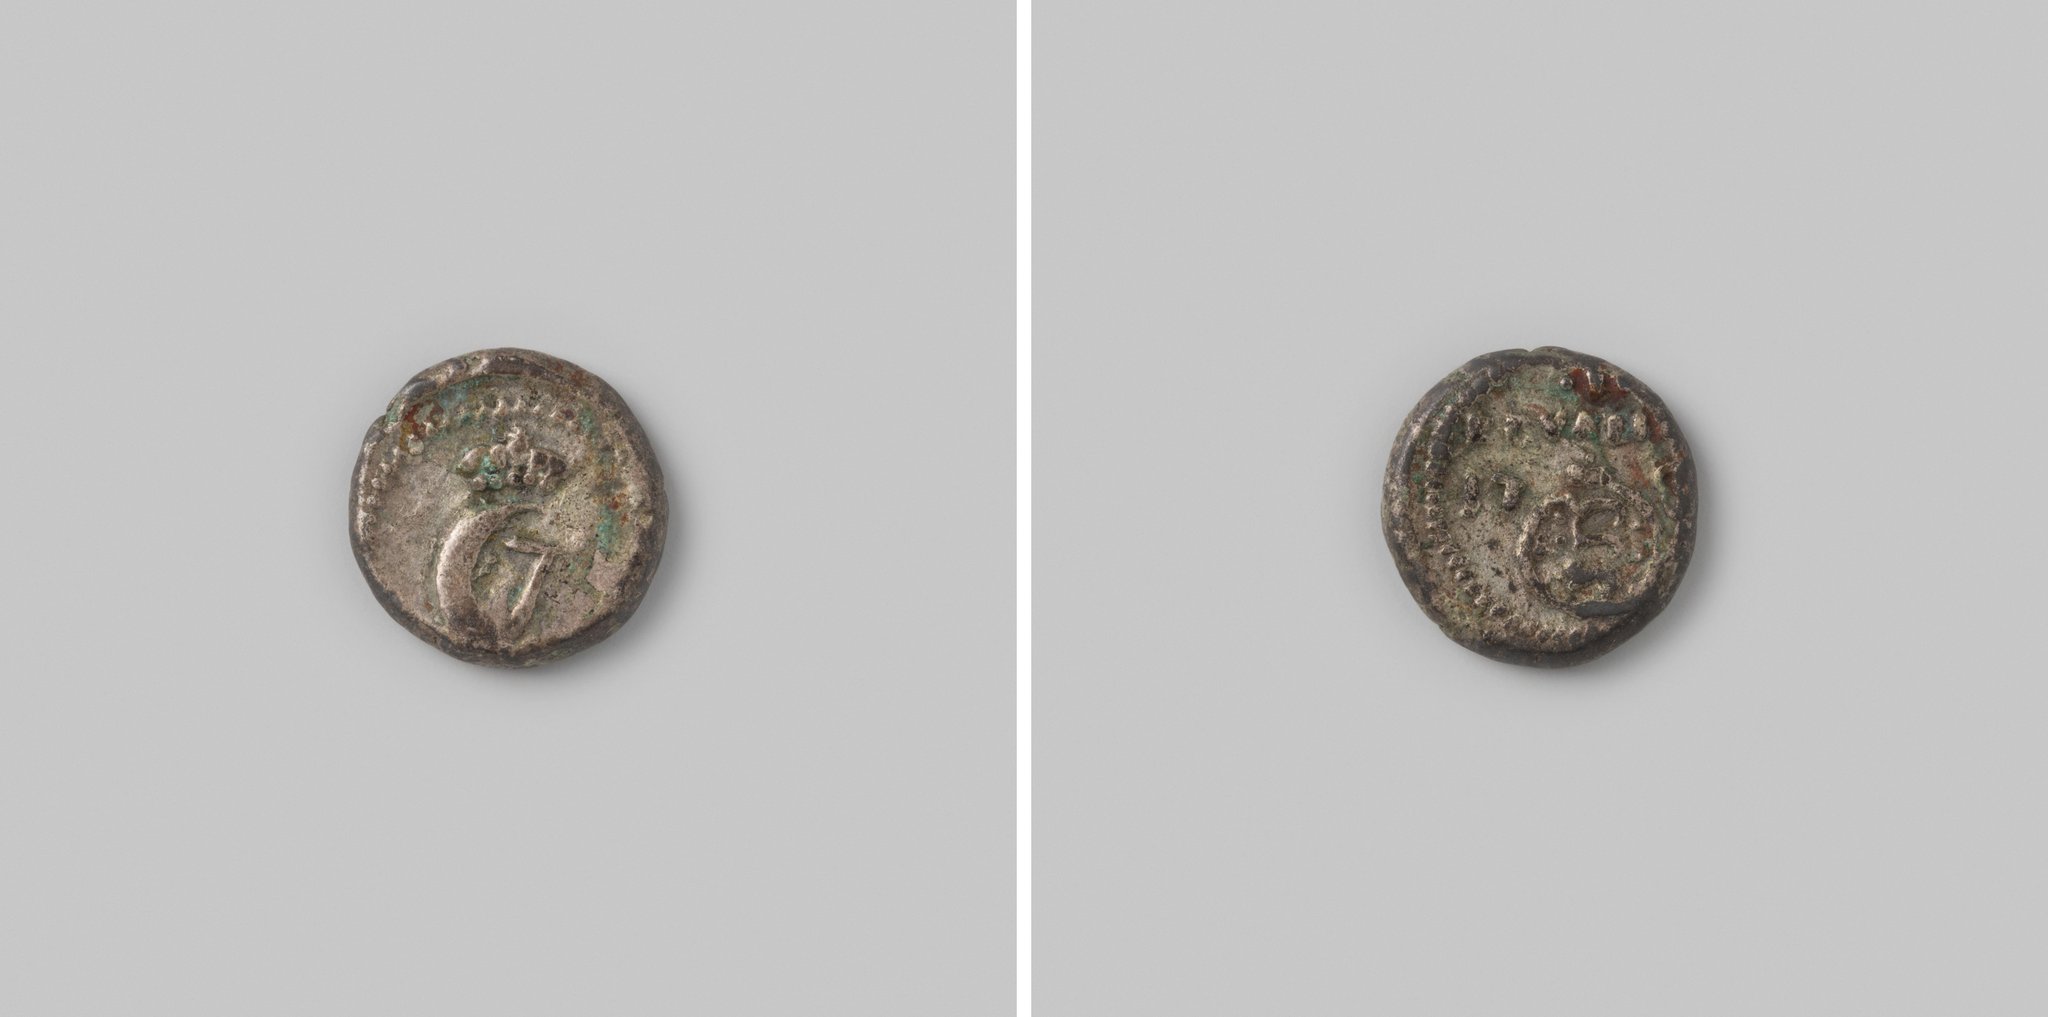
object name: coin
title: Tranquebar, Deens-India, Deense Aziatische Compagnie (DAC) op naam van koning Christiaan VII, royalin, 179[2]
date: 1792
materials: silver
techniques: striking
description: Zilveren munt. Voorzijde: gekroond monogram van de koning. Keerzijde: waarde-aanduiding: 1 royalin in twee regels. Daaronder tussen jaartal gekroond ovaal Deens wapenschild. Gladde rand.